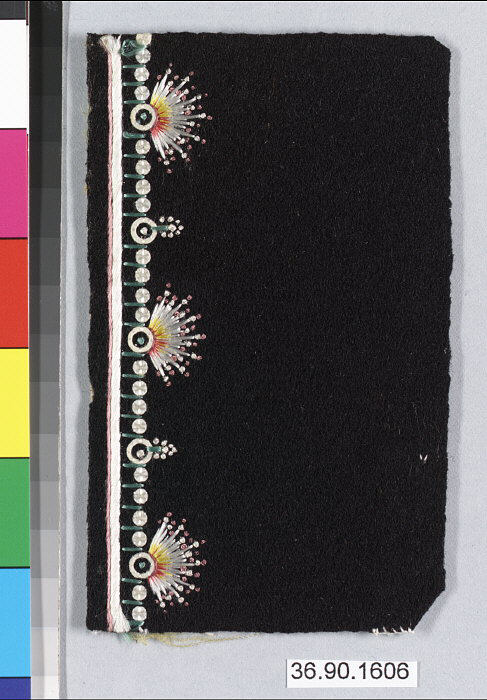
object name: sample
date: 1801-1833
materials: felt, silk